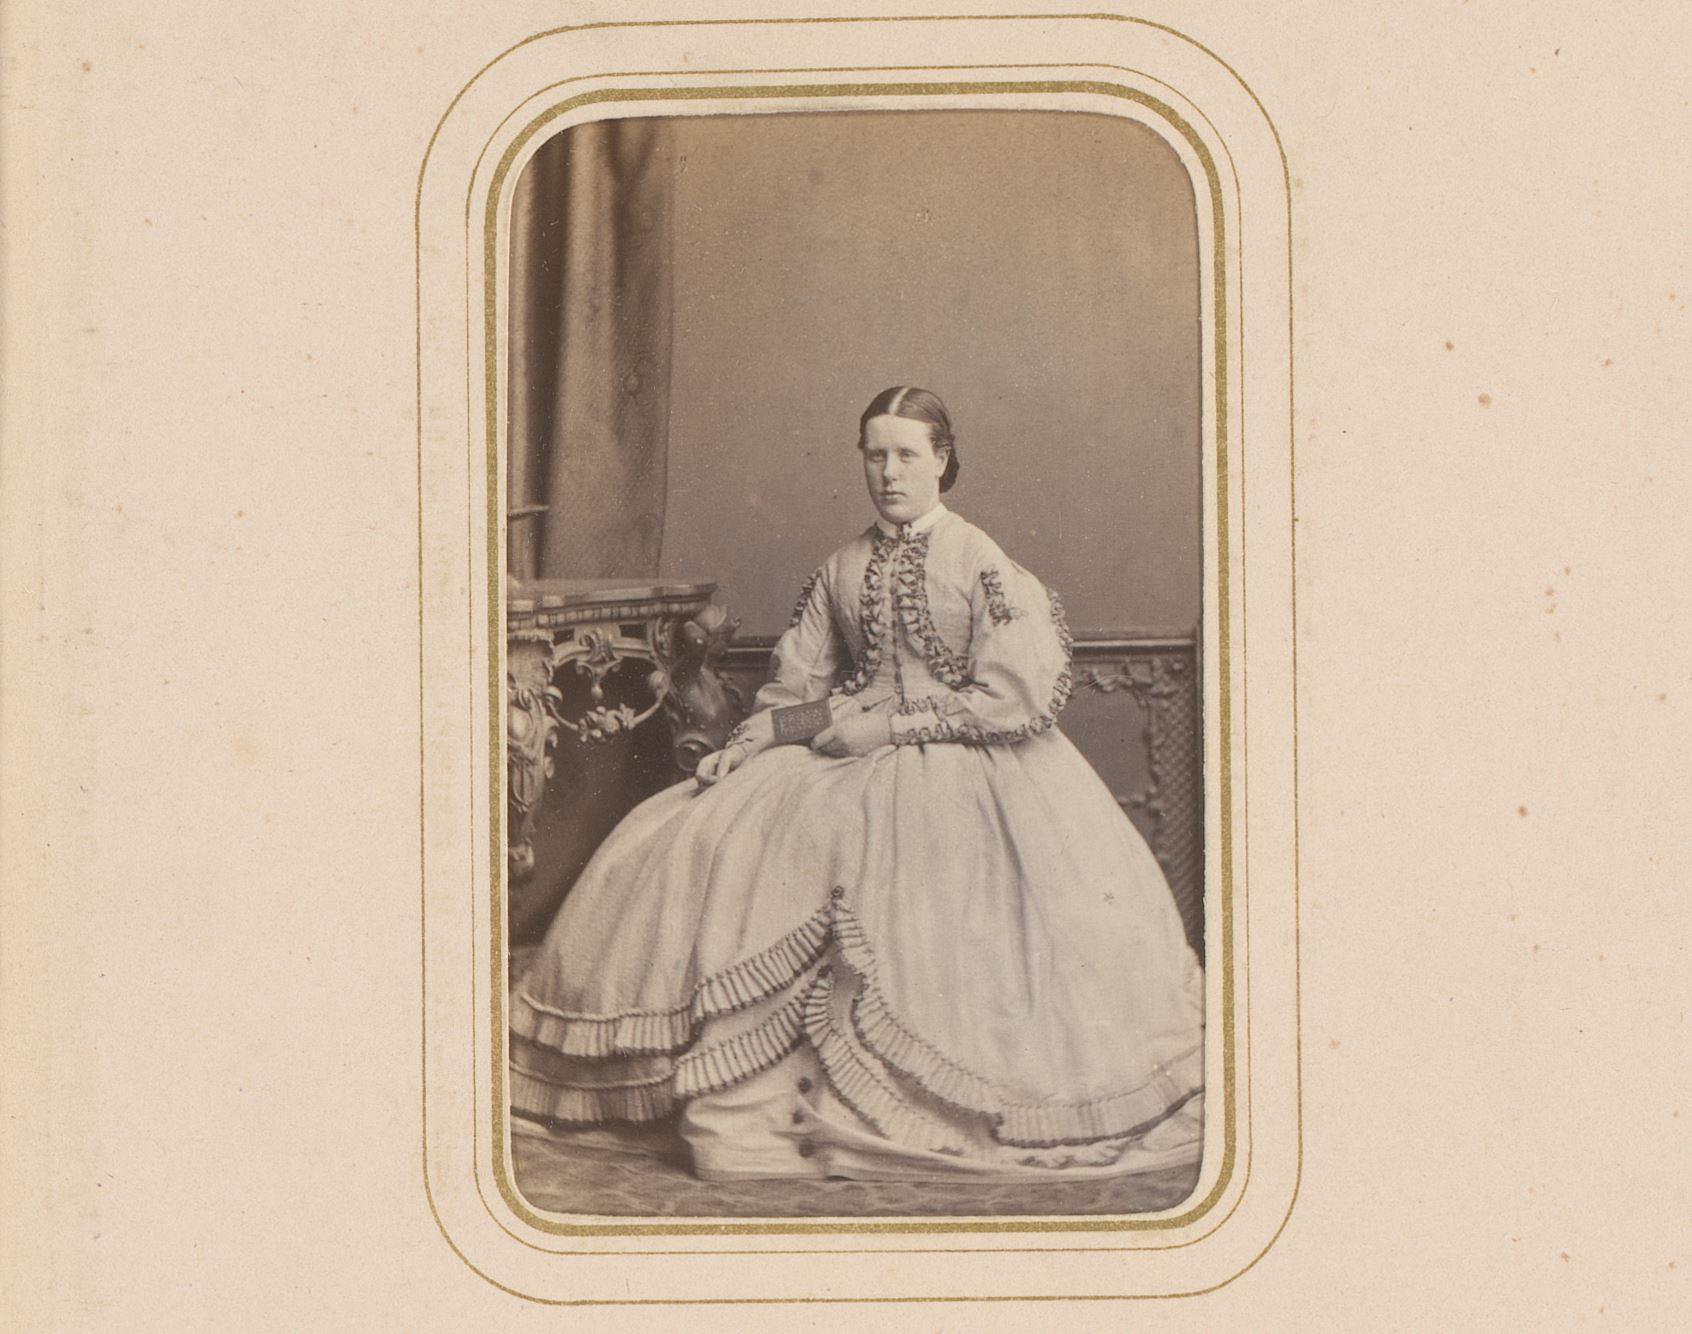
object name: carte de visite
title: Portret van een zittende vrouw met boek in de hand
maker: charles thomas newcombe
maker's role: fotograaf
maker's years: 1830-1912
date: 1855-1881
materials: cardboard, photographic support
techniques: albumen print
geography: hastings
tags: sitting figure - aa - female human figure, historical persons - bb - woman, book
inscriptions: inscription: ‘No. 2888/ C. T. NEWCOMBE, PHOTOGRAPHER/ HASTINGS/ And at 109, Regent Street, W./ and 135, Fenchurch St. City.’